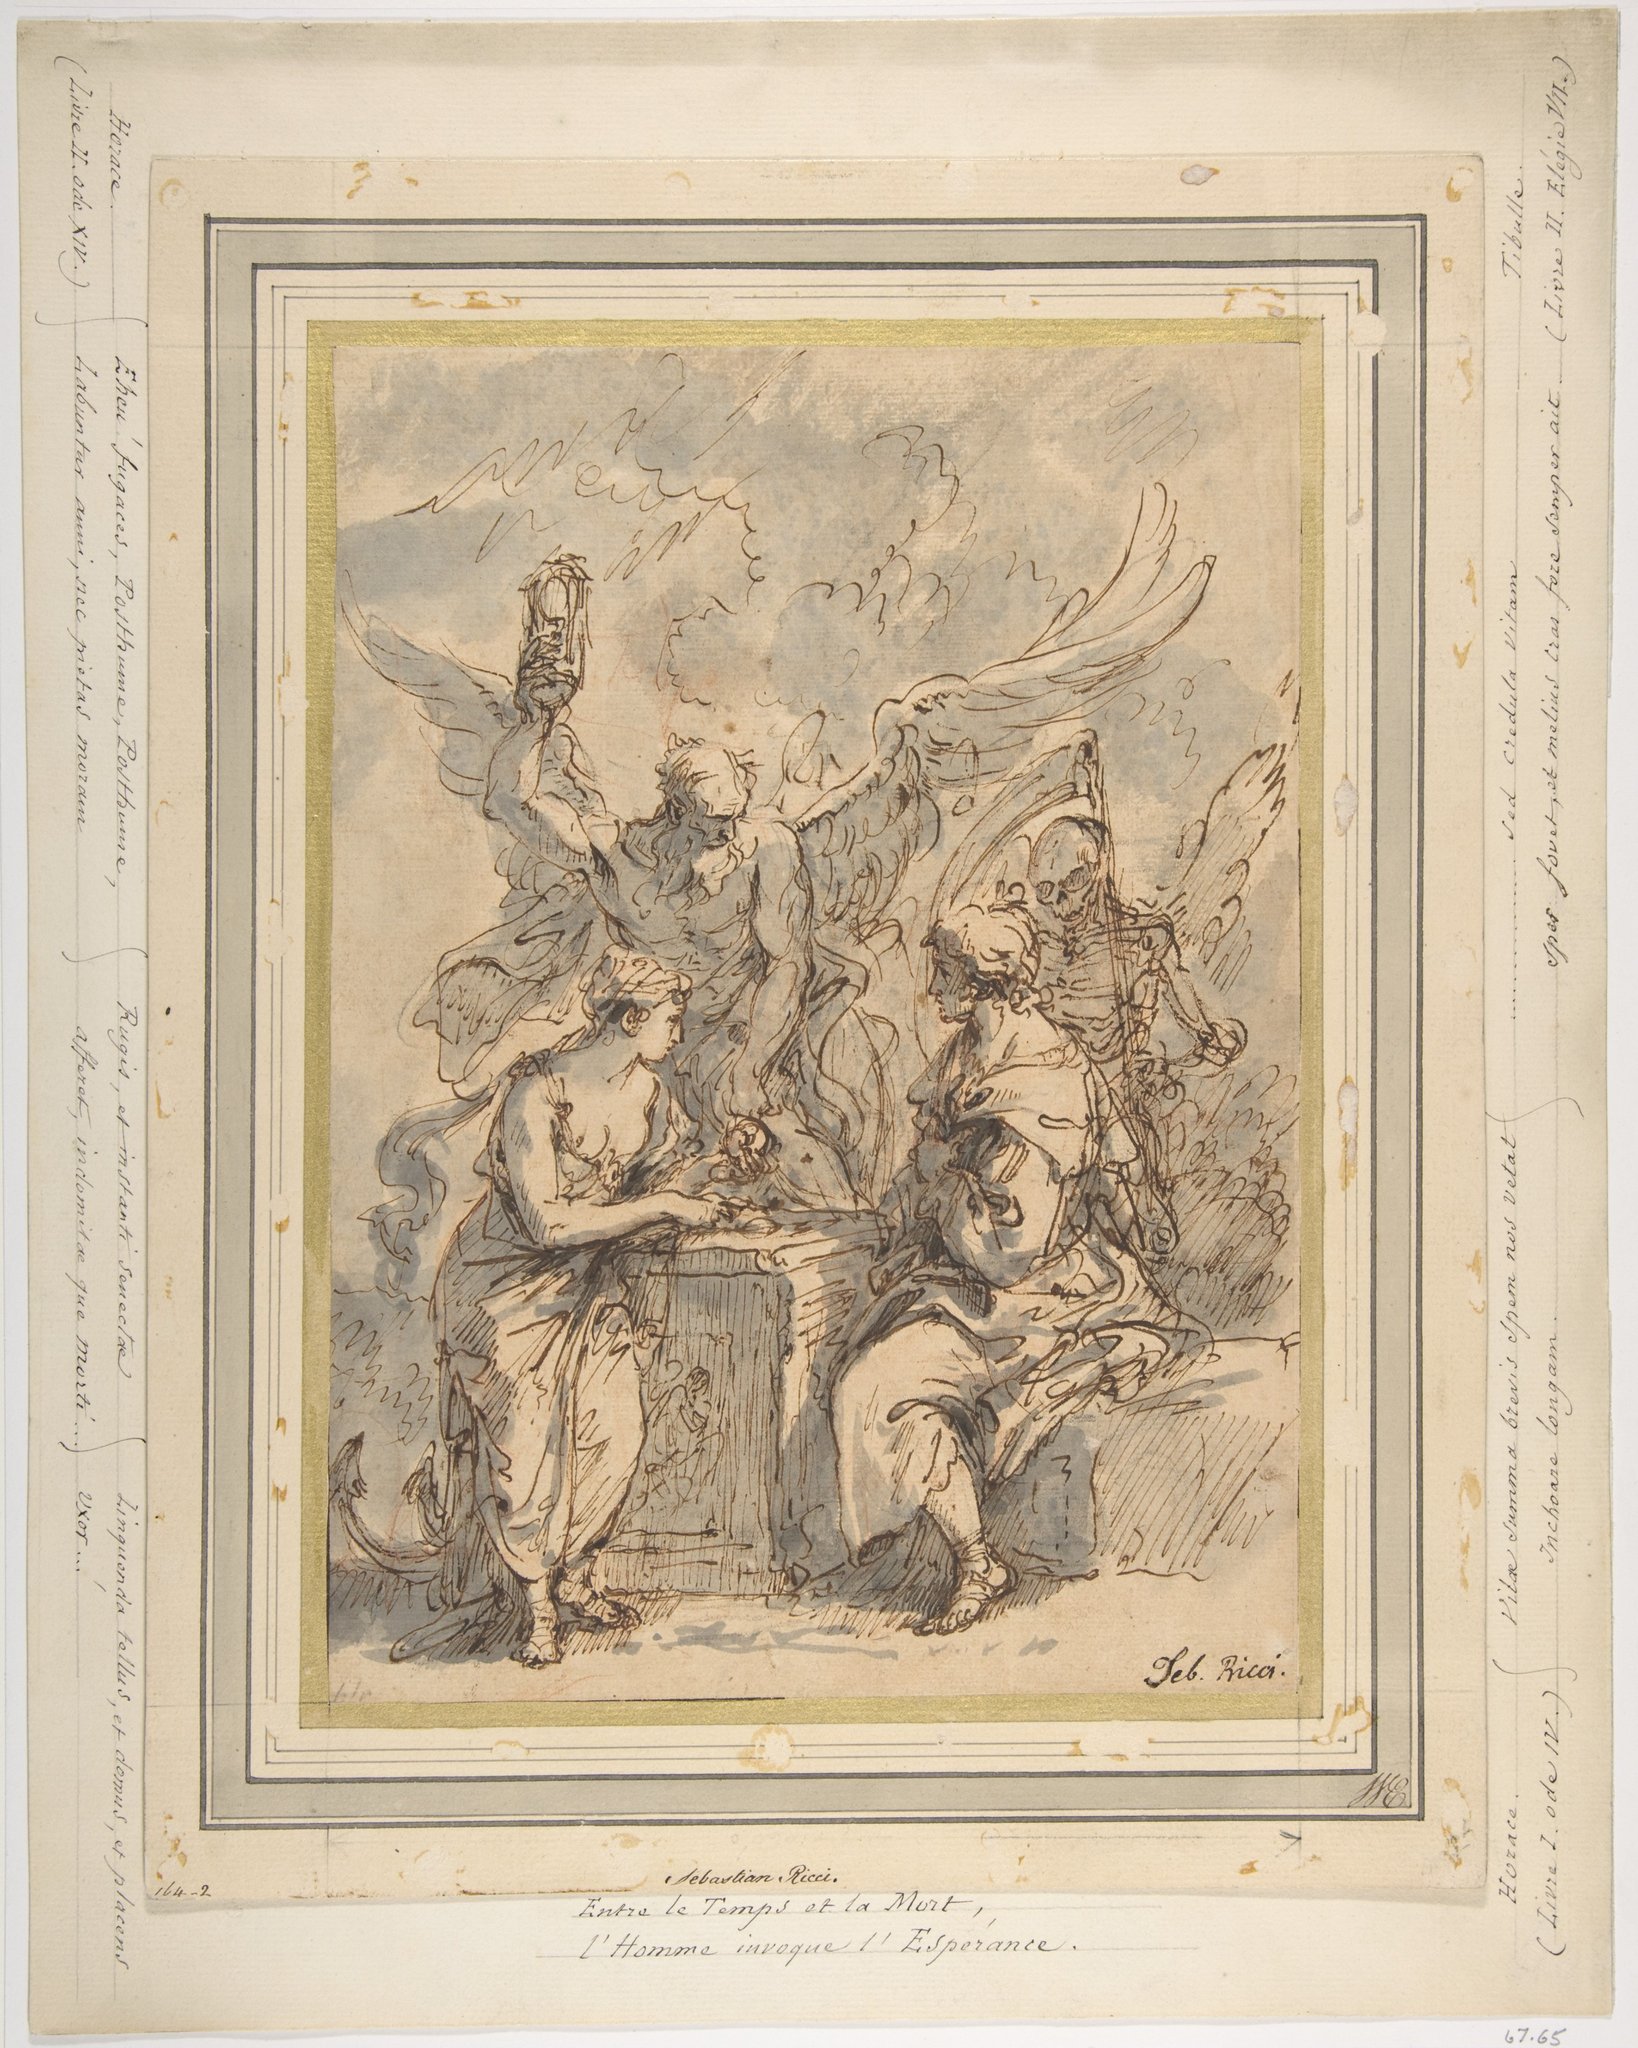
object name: drawing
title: Allegory with Figures of Hope, Time, and Death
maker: sebastiano ricci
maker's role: artist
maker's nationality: italian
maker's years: 1659-1734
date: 1659-1734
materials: chalk, ink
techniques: brush, pen, wash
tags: human figures